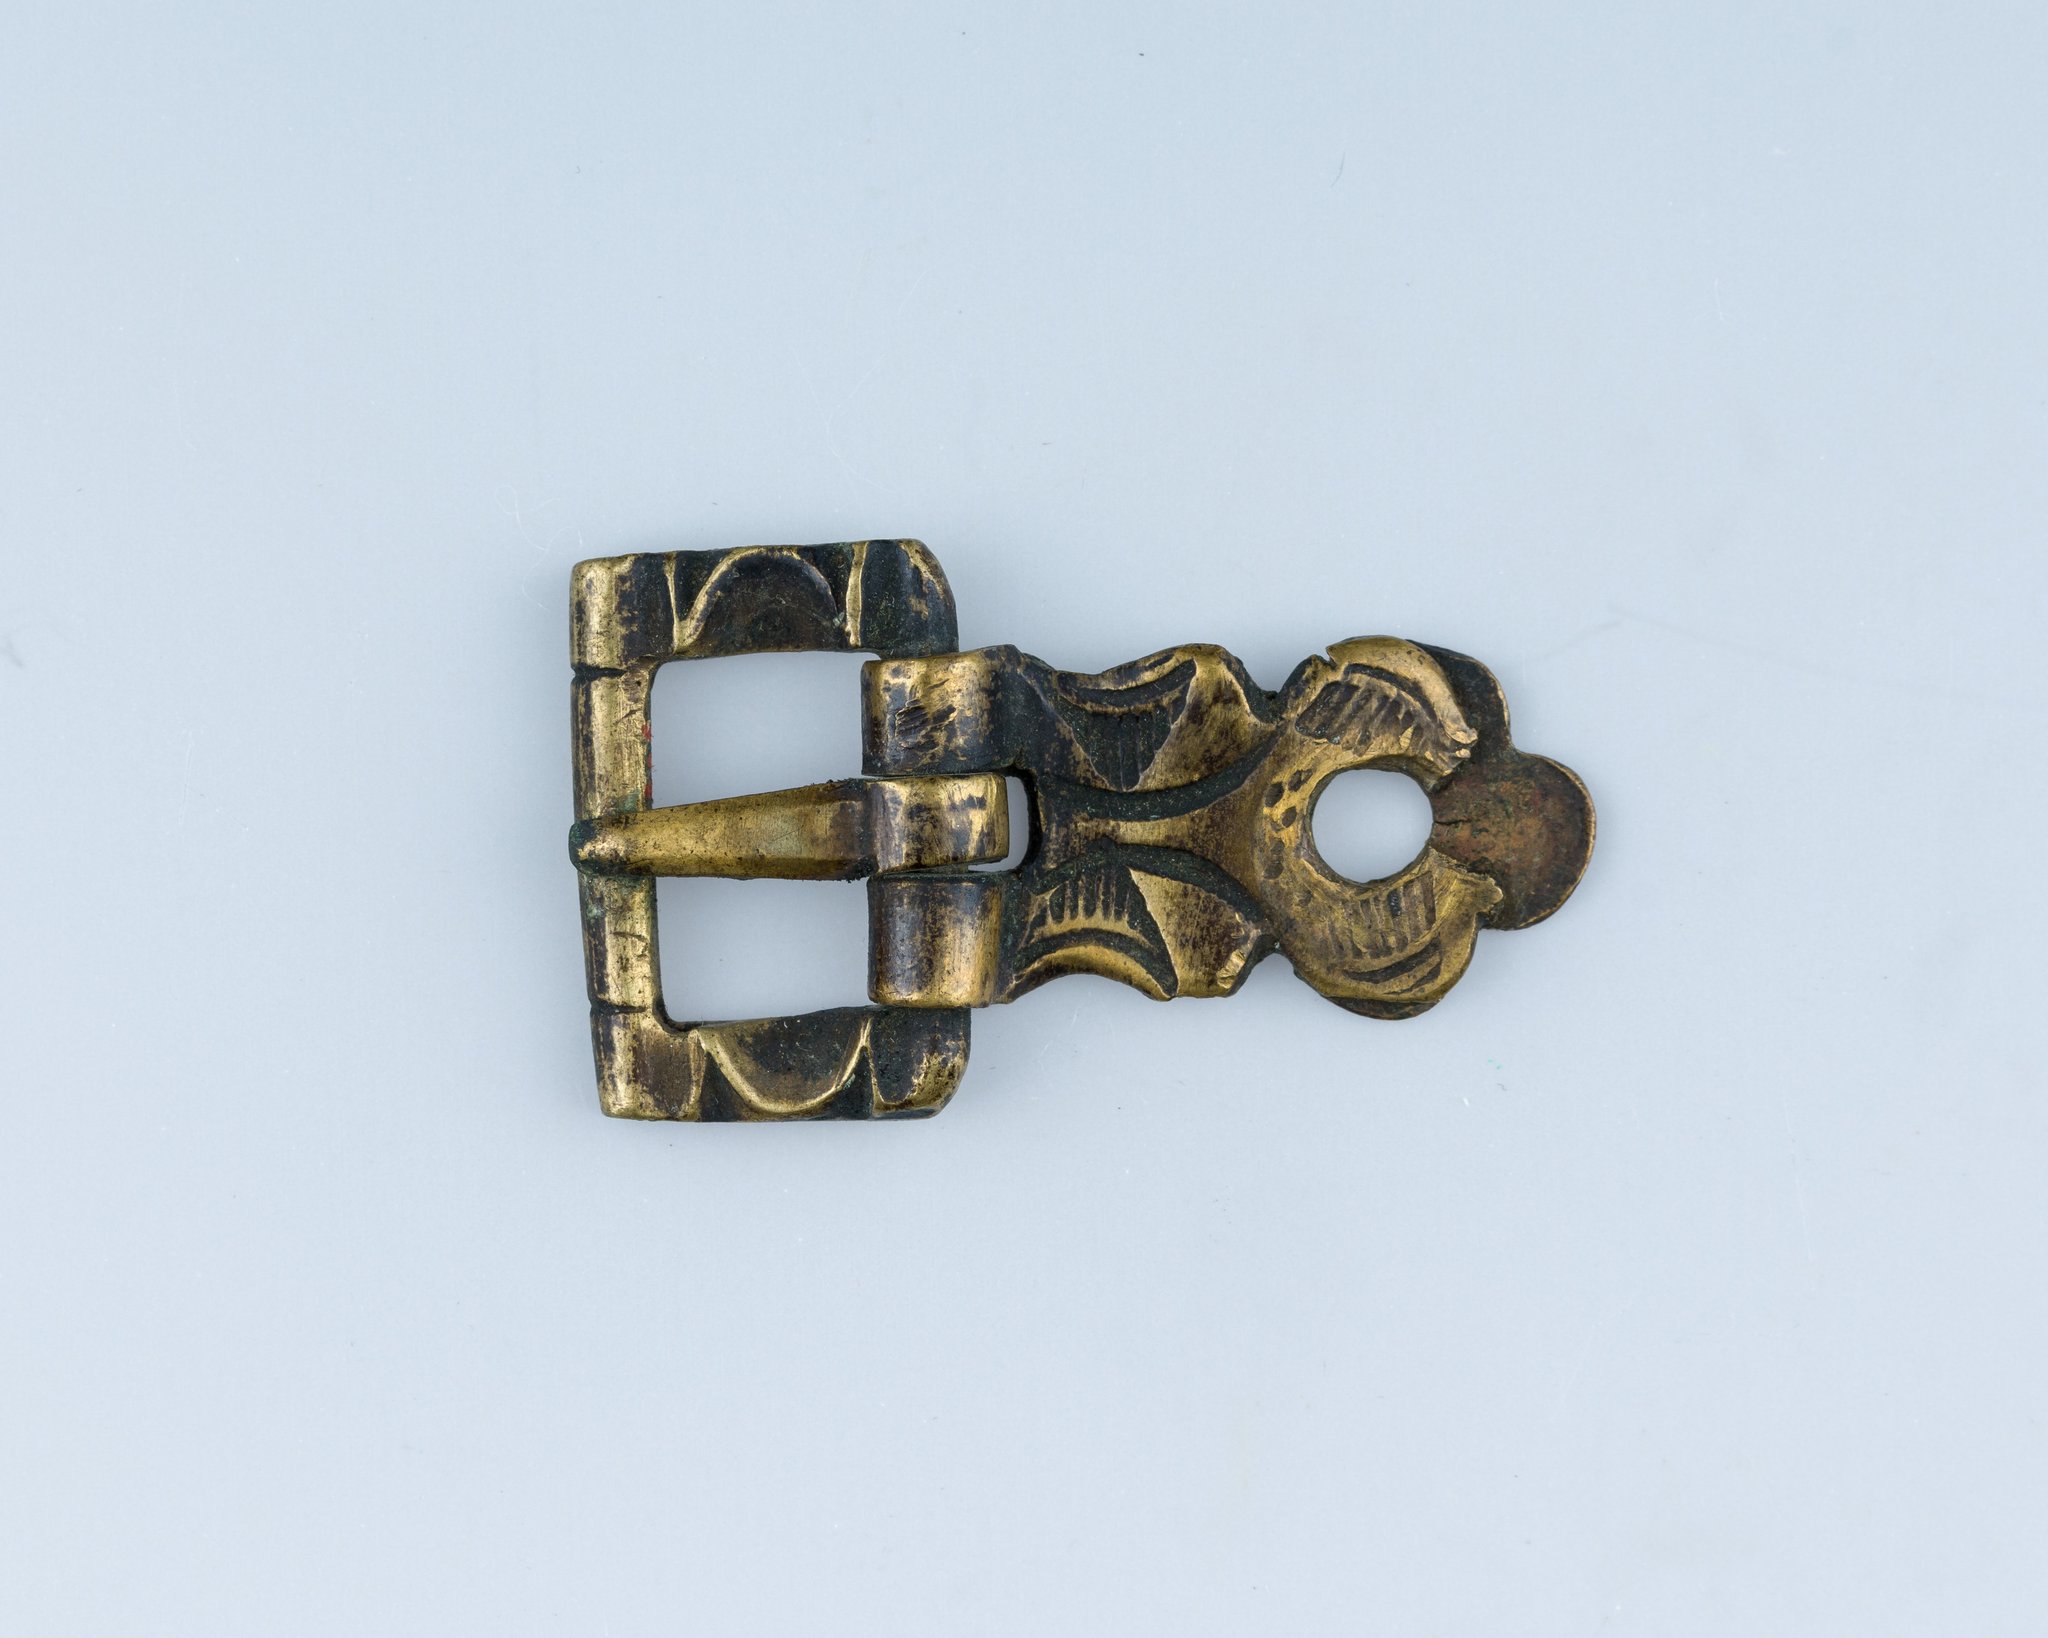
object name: buckle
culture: german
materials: brass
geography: germany